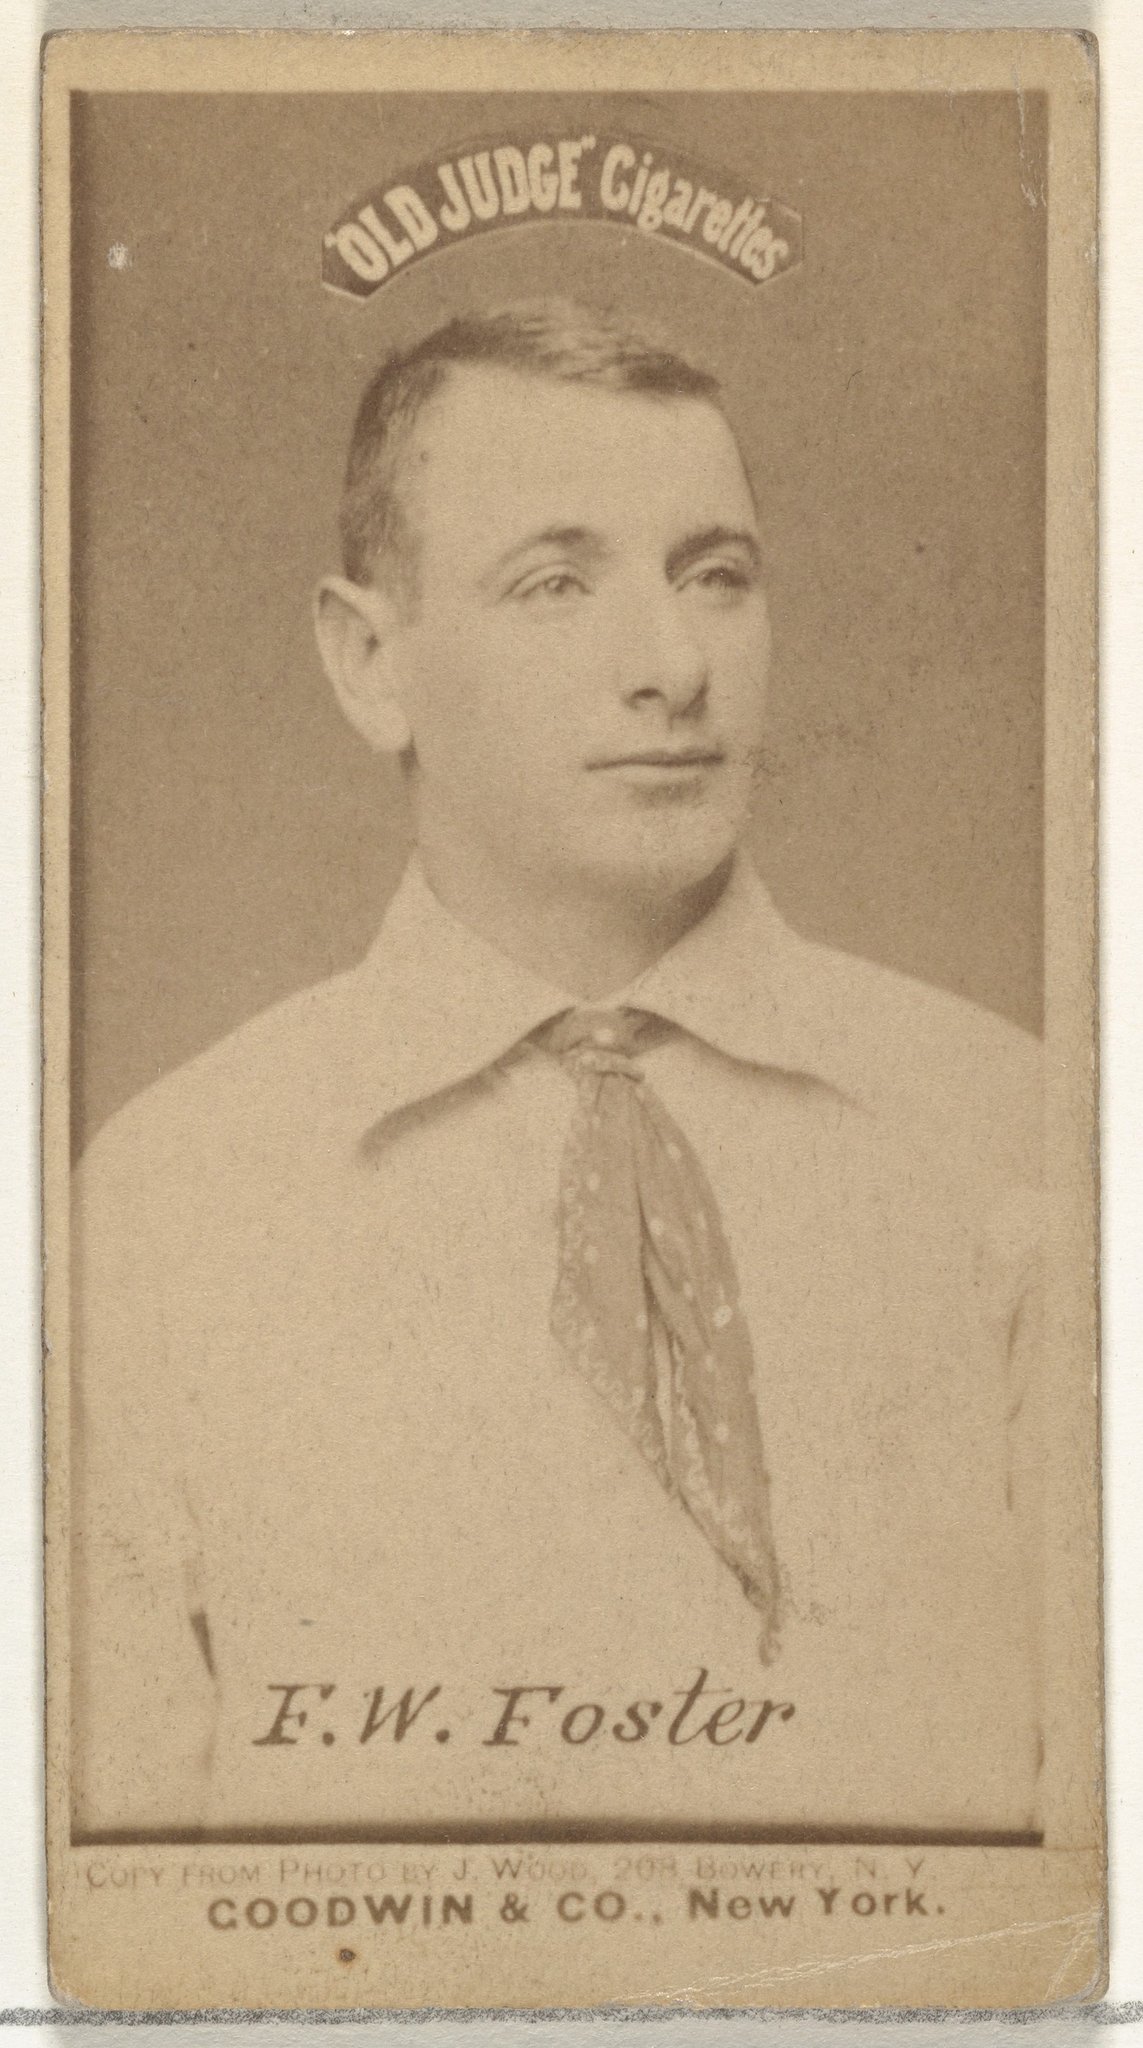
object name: baseball card, photograph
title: F.W. Foster, from the Old Judge series (N172) for Old Judge Cigarettes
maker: goodwin & company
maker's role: publisher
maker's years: 1850-1950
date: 1887-1890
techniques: albumen silver print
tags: men,portraits,baseball,athletes